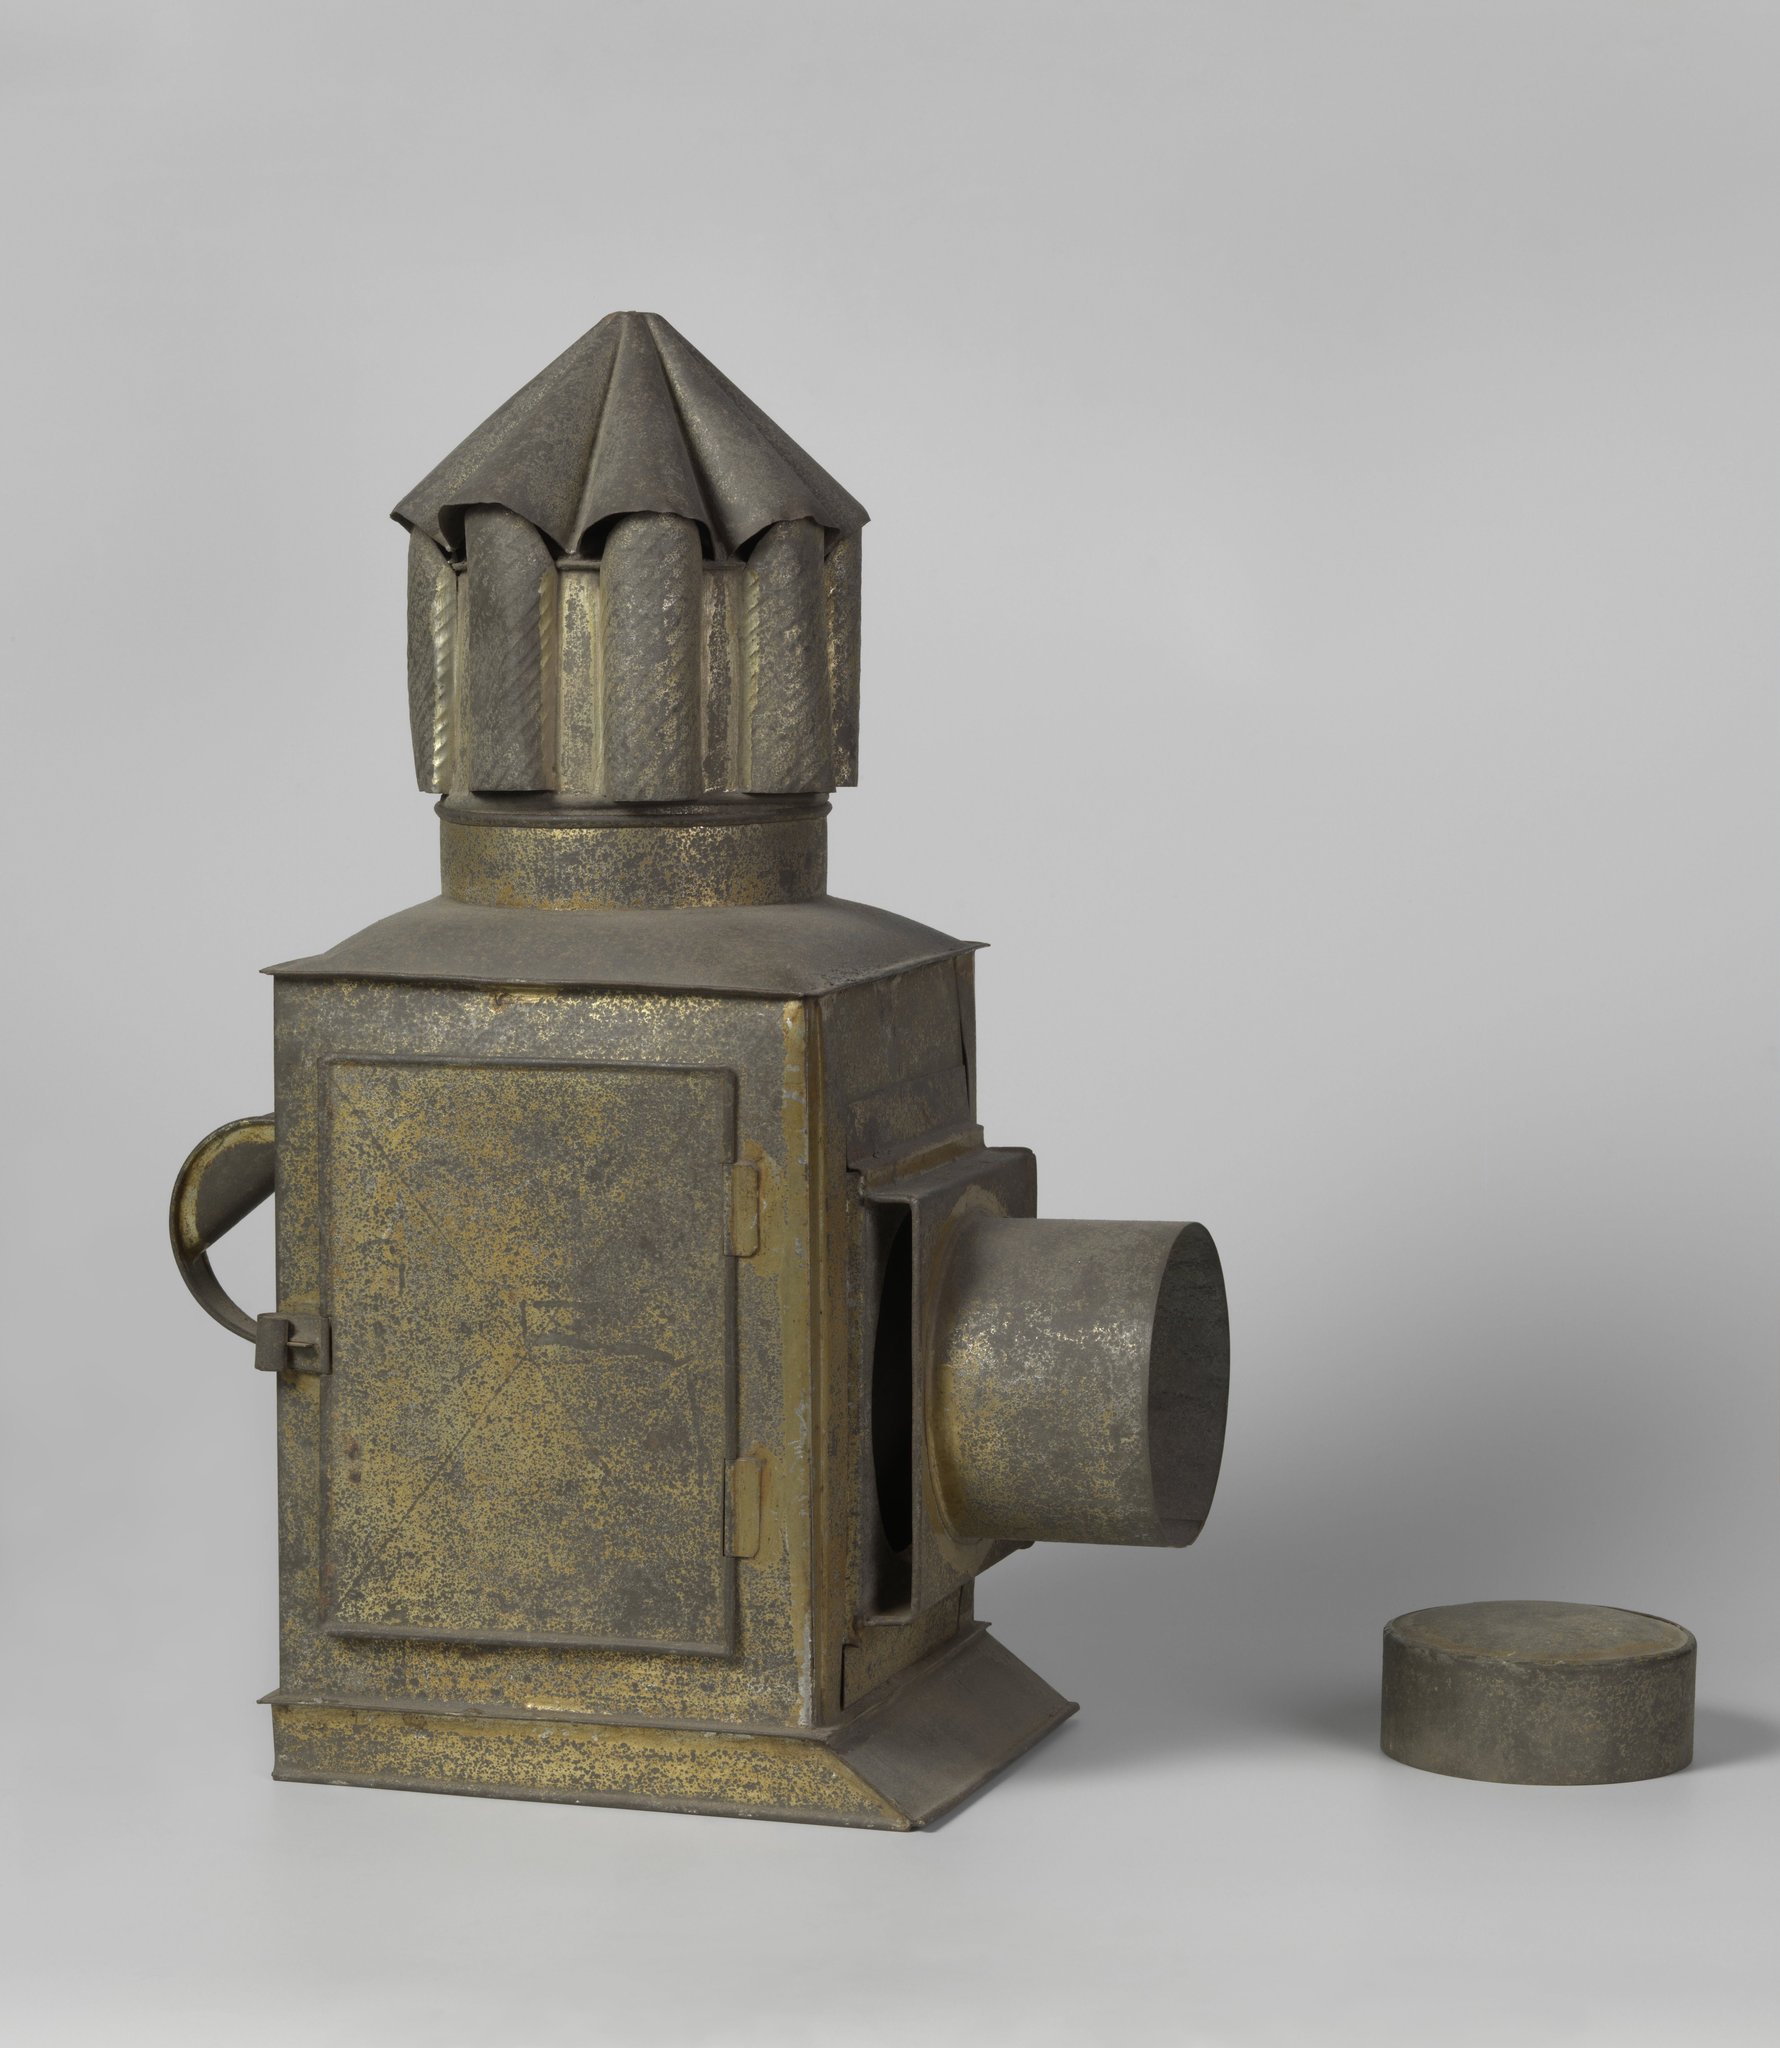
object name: magic lantern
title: Toverlantaarn, zwart verlakt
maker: Anonymous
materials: metal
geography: netherlands